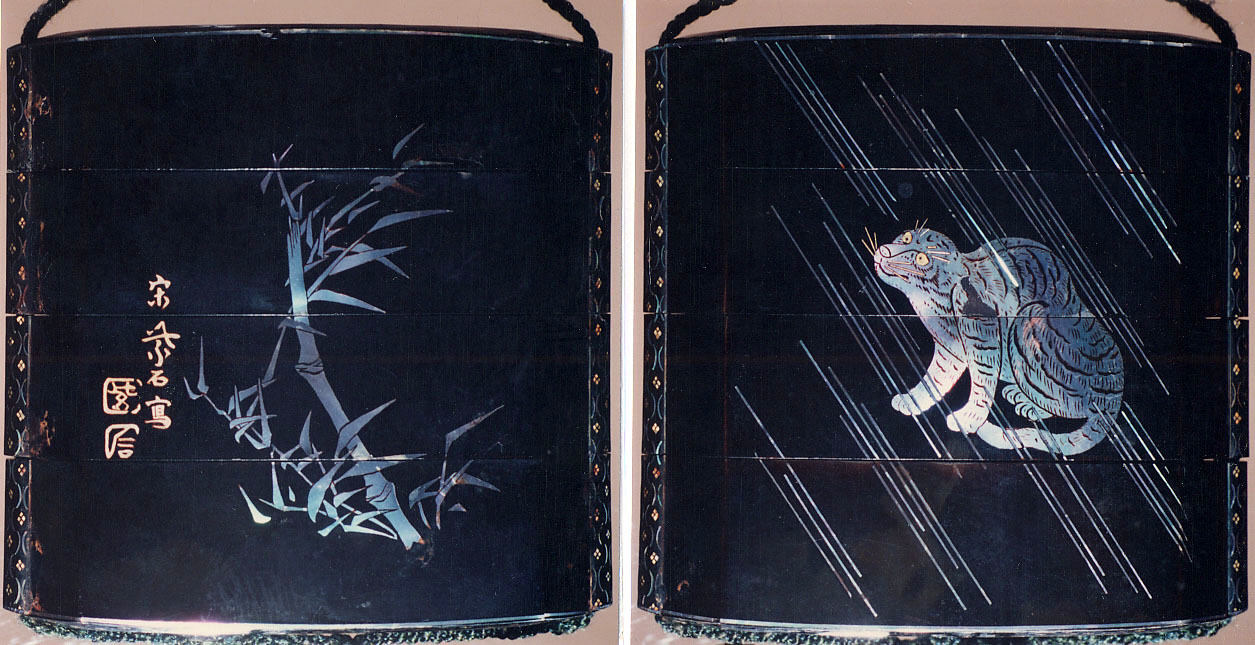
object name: inrō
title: Case (Inrō) with Design of Seated Tiger in Rain (obverse); Bamboo with Inscription (reverse)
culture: japanese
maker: sō shiseki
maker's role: artist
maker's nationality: japanese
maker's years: 1715-1786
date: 1801-1900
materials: gold foil, lacquer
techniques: inlay, roiro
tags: tigers,bamboo,rain